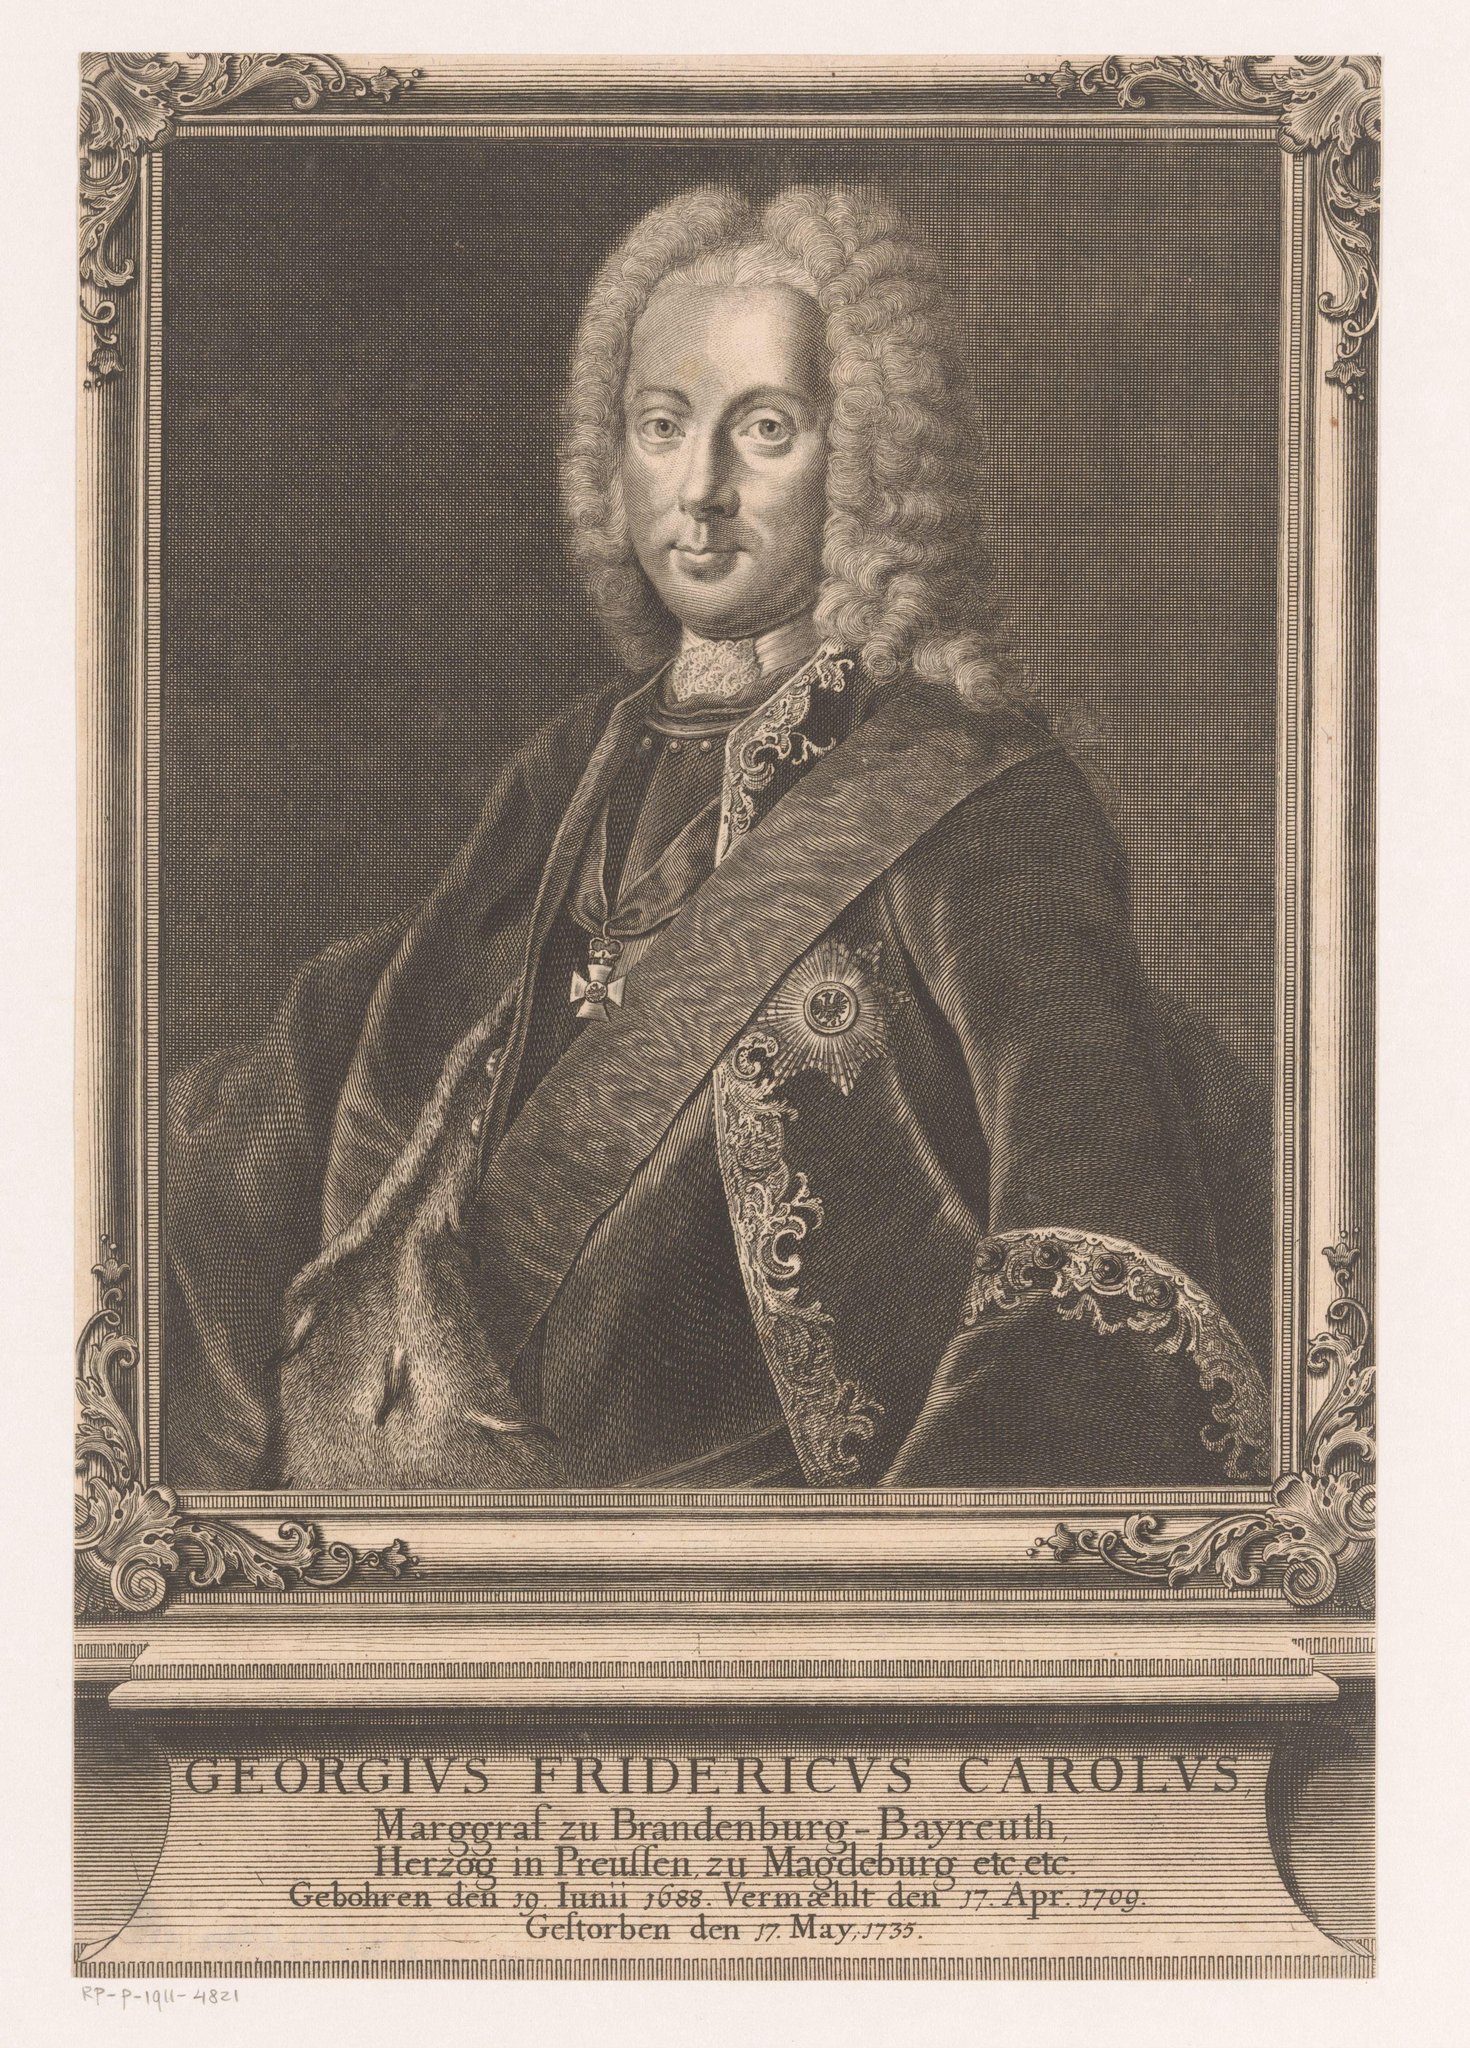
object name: print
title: Portret van George Frederik Karel van Brandenburg-Bayreuth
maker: johann wilhelm windter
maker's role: draughtsman, print maker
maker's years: 1696-1765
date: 1745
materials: paper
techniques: engraving, etching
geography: germany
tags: historical persons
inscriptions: collector's mark: Lugt 2228